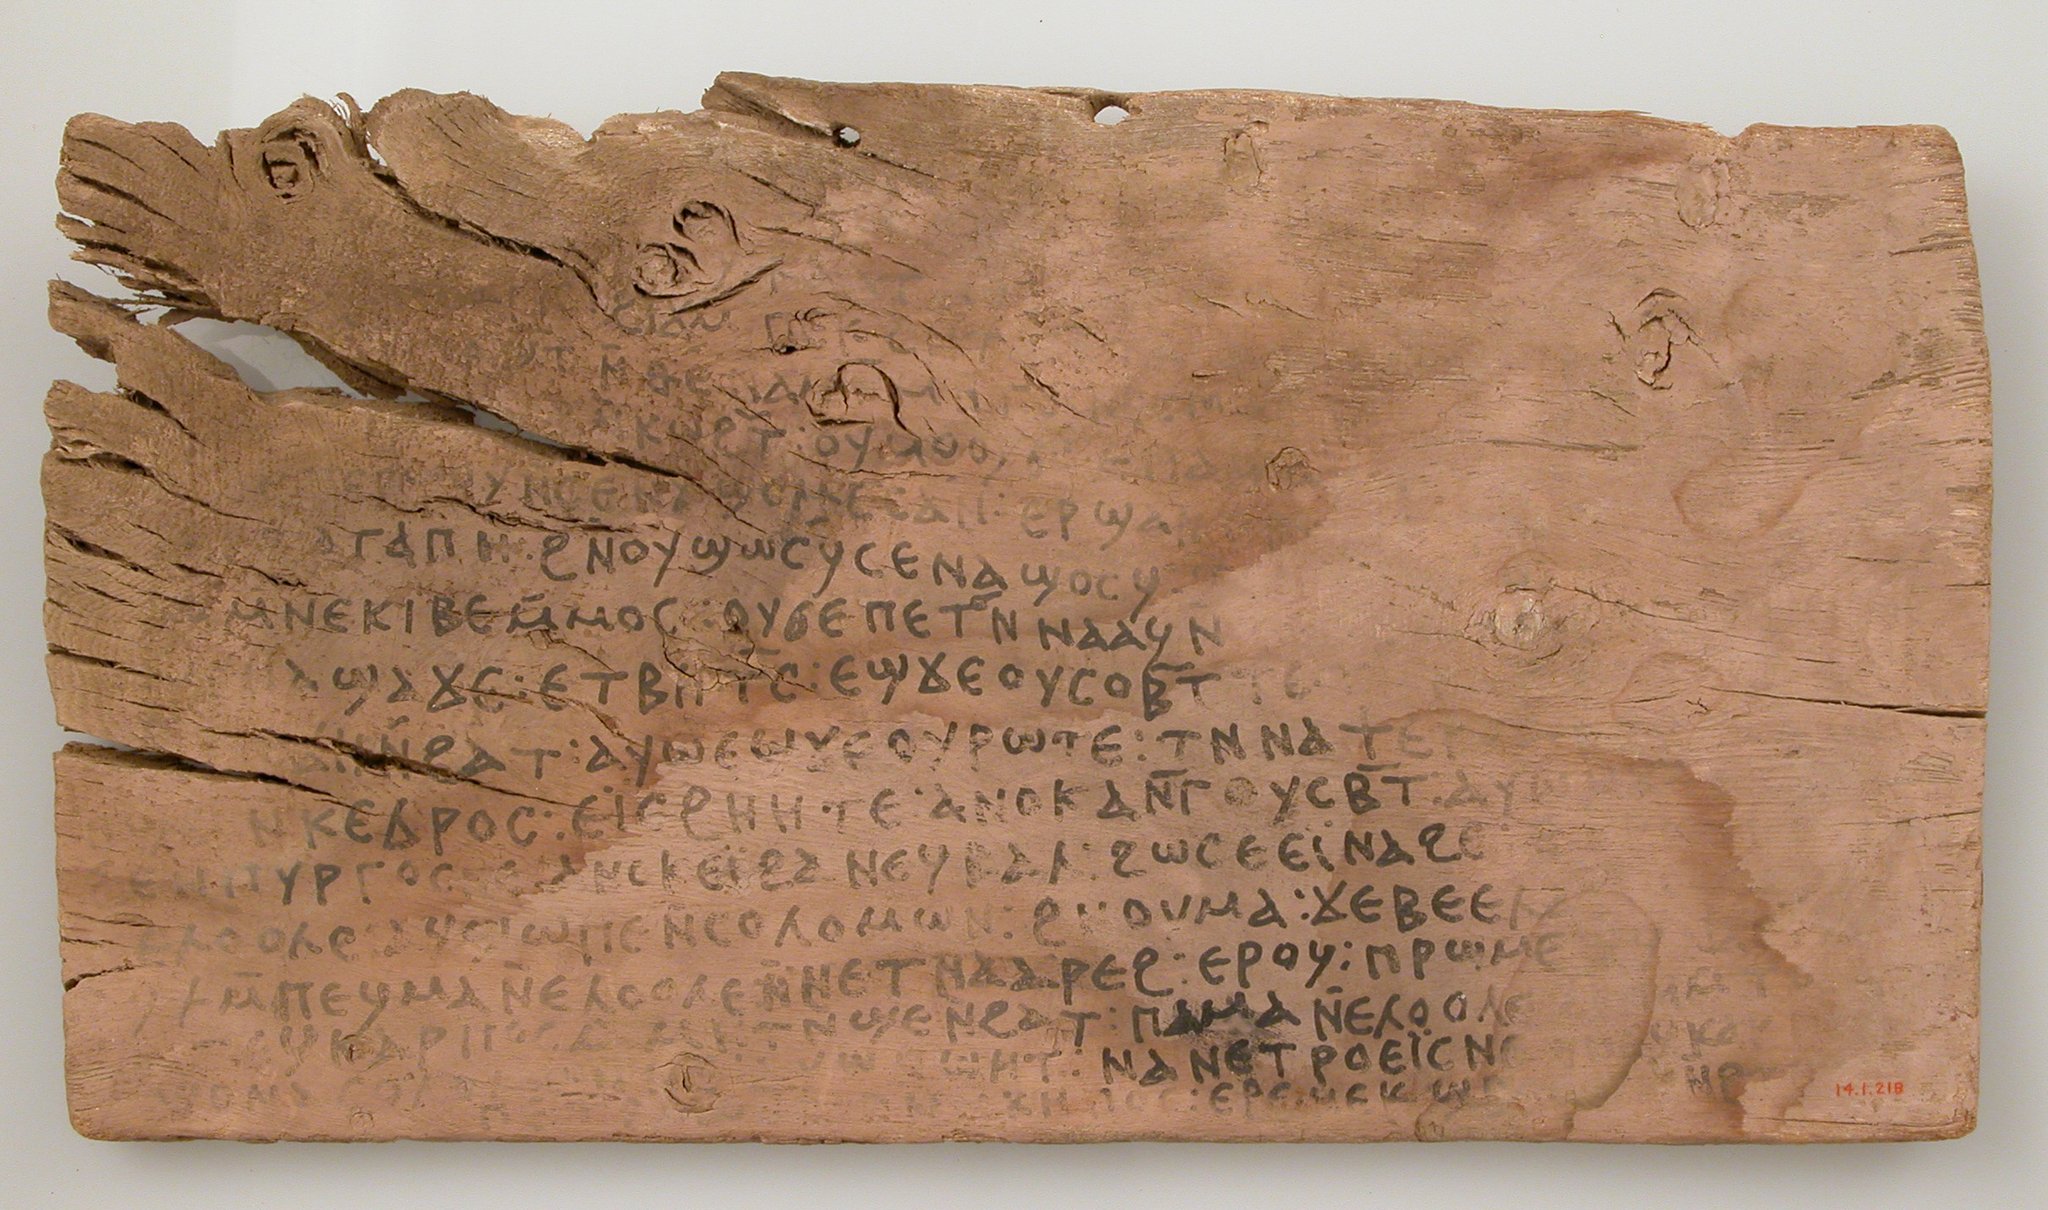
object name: ostrakon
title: Ostrakon with Text from Song of Songs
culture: coptic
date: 580-640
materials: ink, wood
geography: egypt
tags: coptic,documents